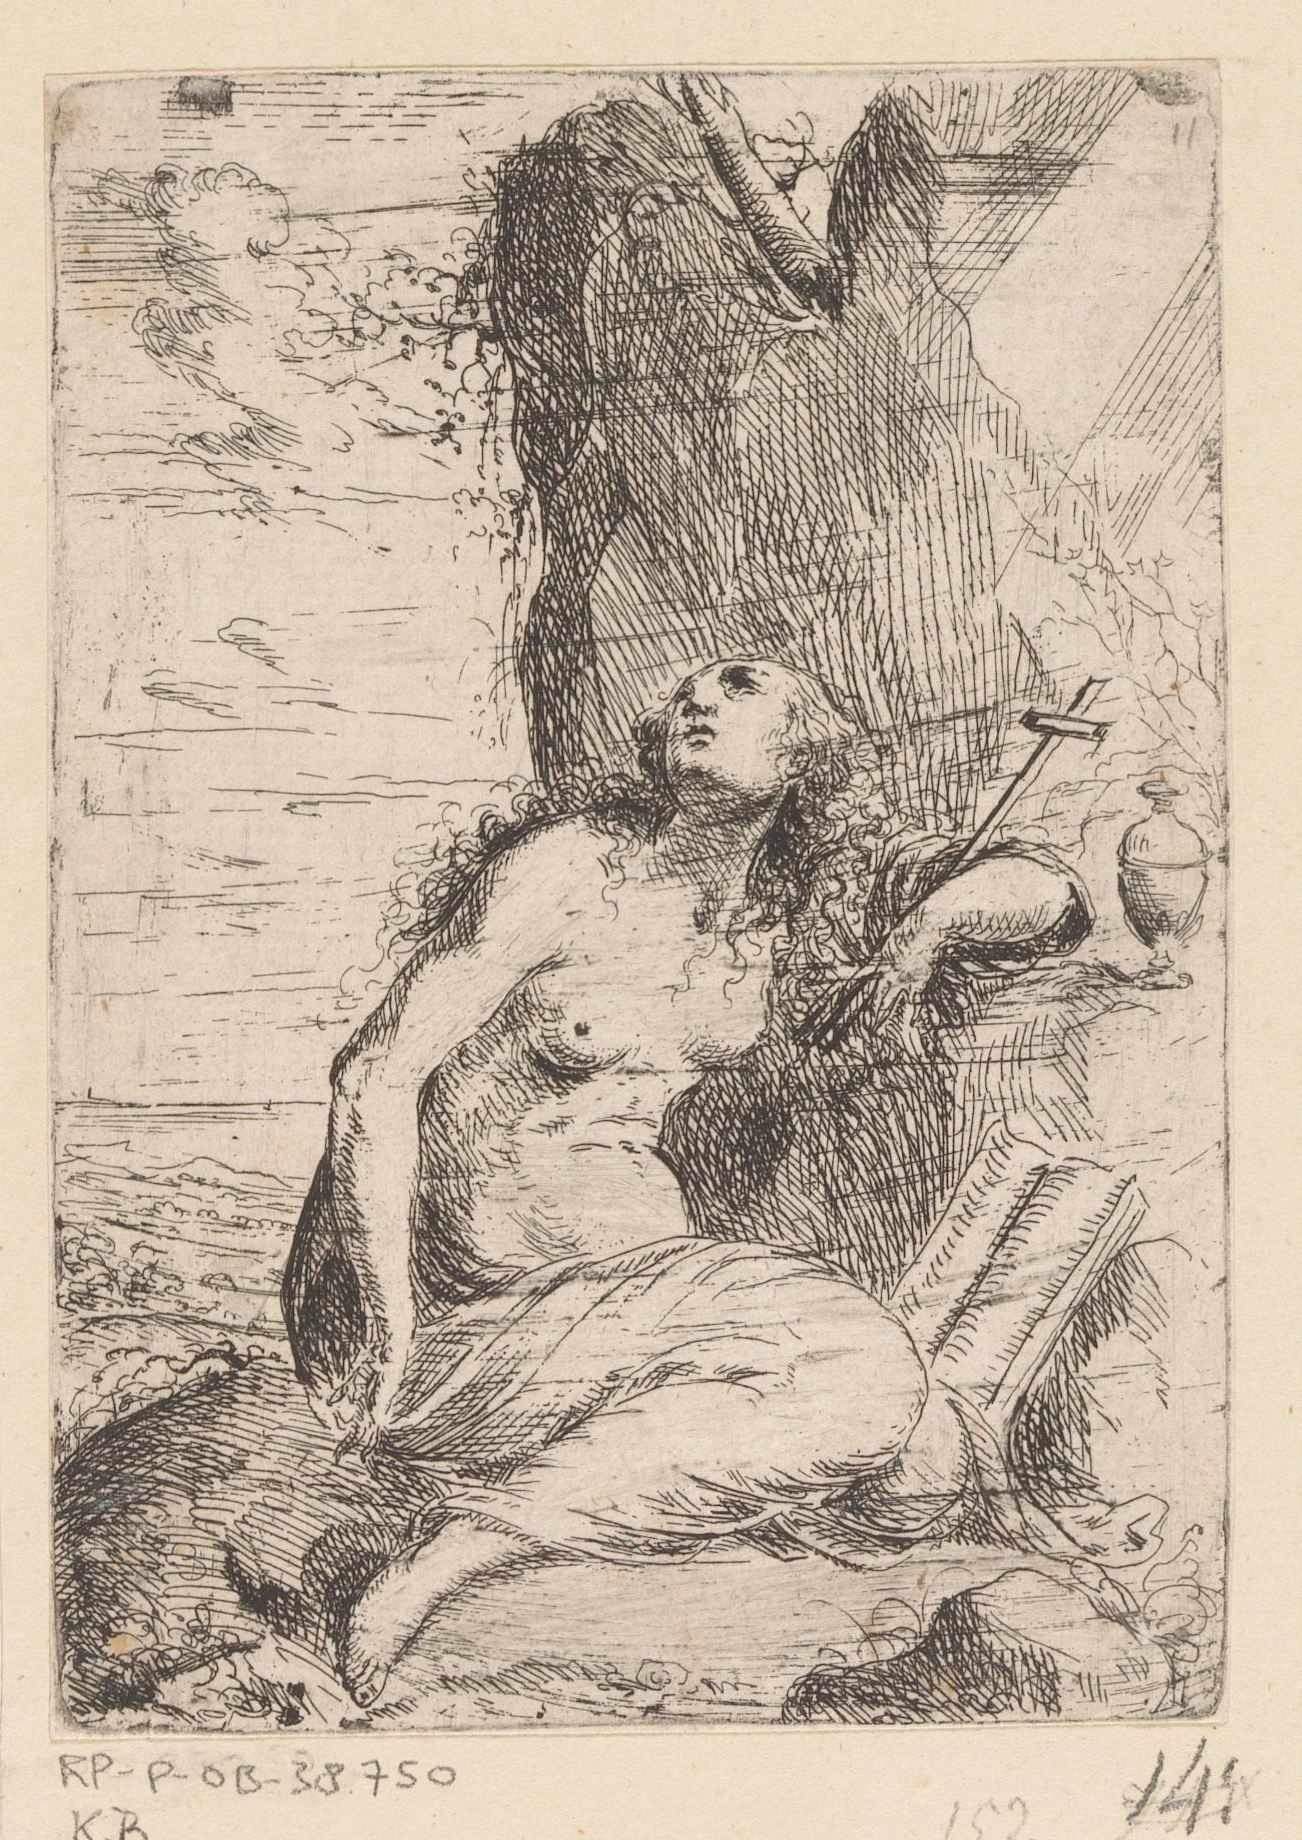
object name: print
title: Maria Magdalena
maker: Anonymous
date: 1600-1699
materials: paper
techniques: etching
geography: italy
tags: the penitent harlot mary magdalene; possible attributes: book (or scroll), crown, crown of thorns, crucifix, jar of ointment, mirror, musical instrument, palm-branch, rosary, scourge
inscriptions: collector's mark: Lugt 240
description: Maria Magdalena in een landschap met een kruis, een boek en de zalfpot.